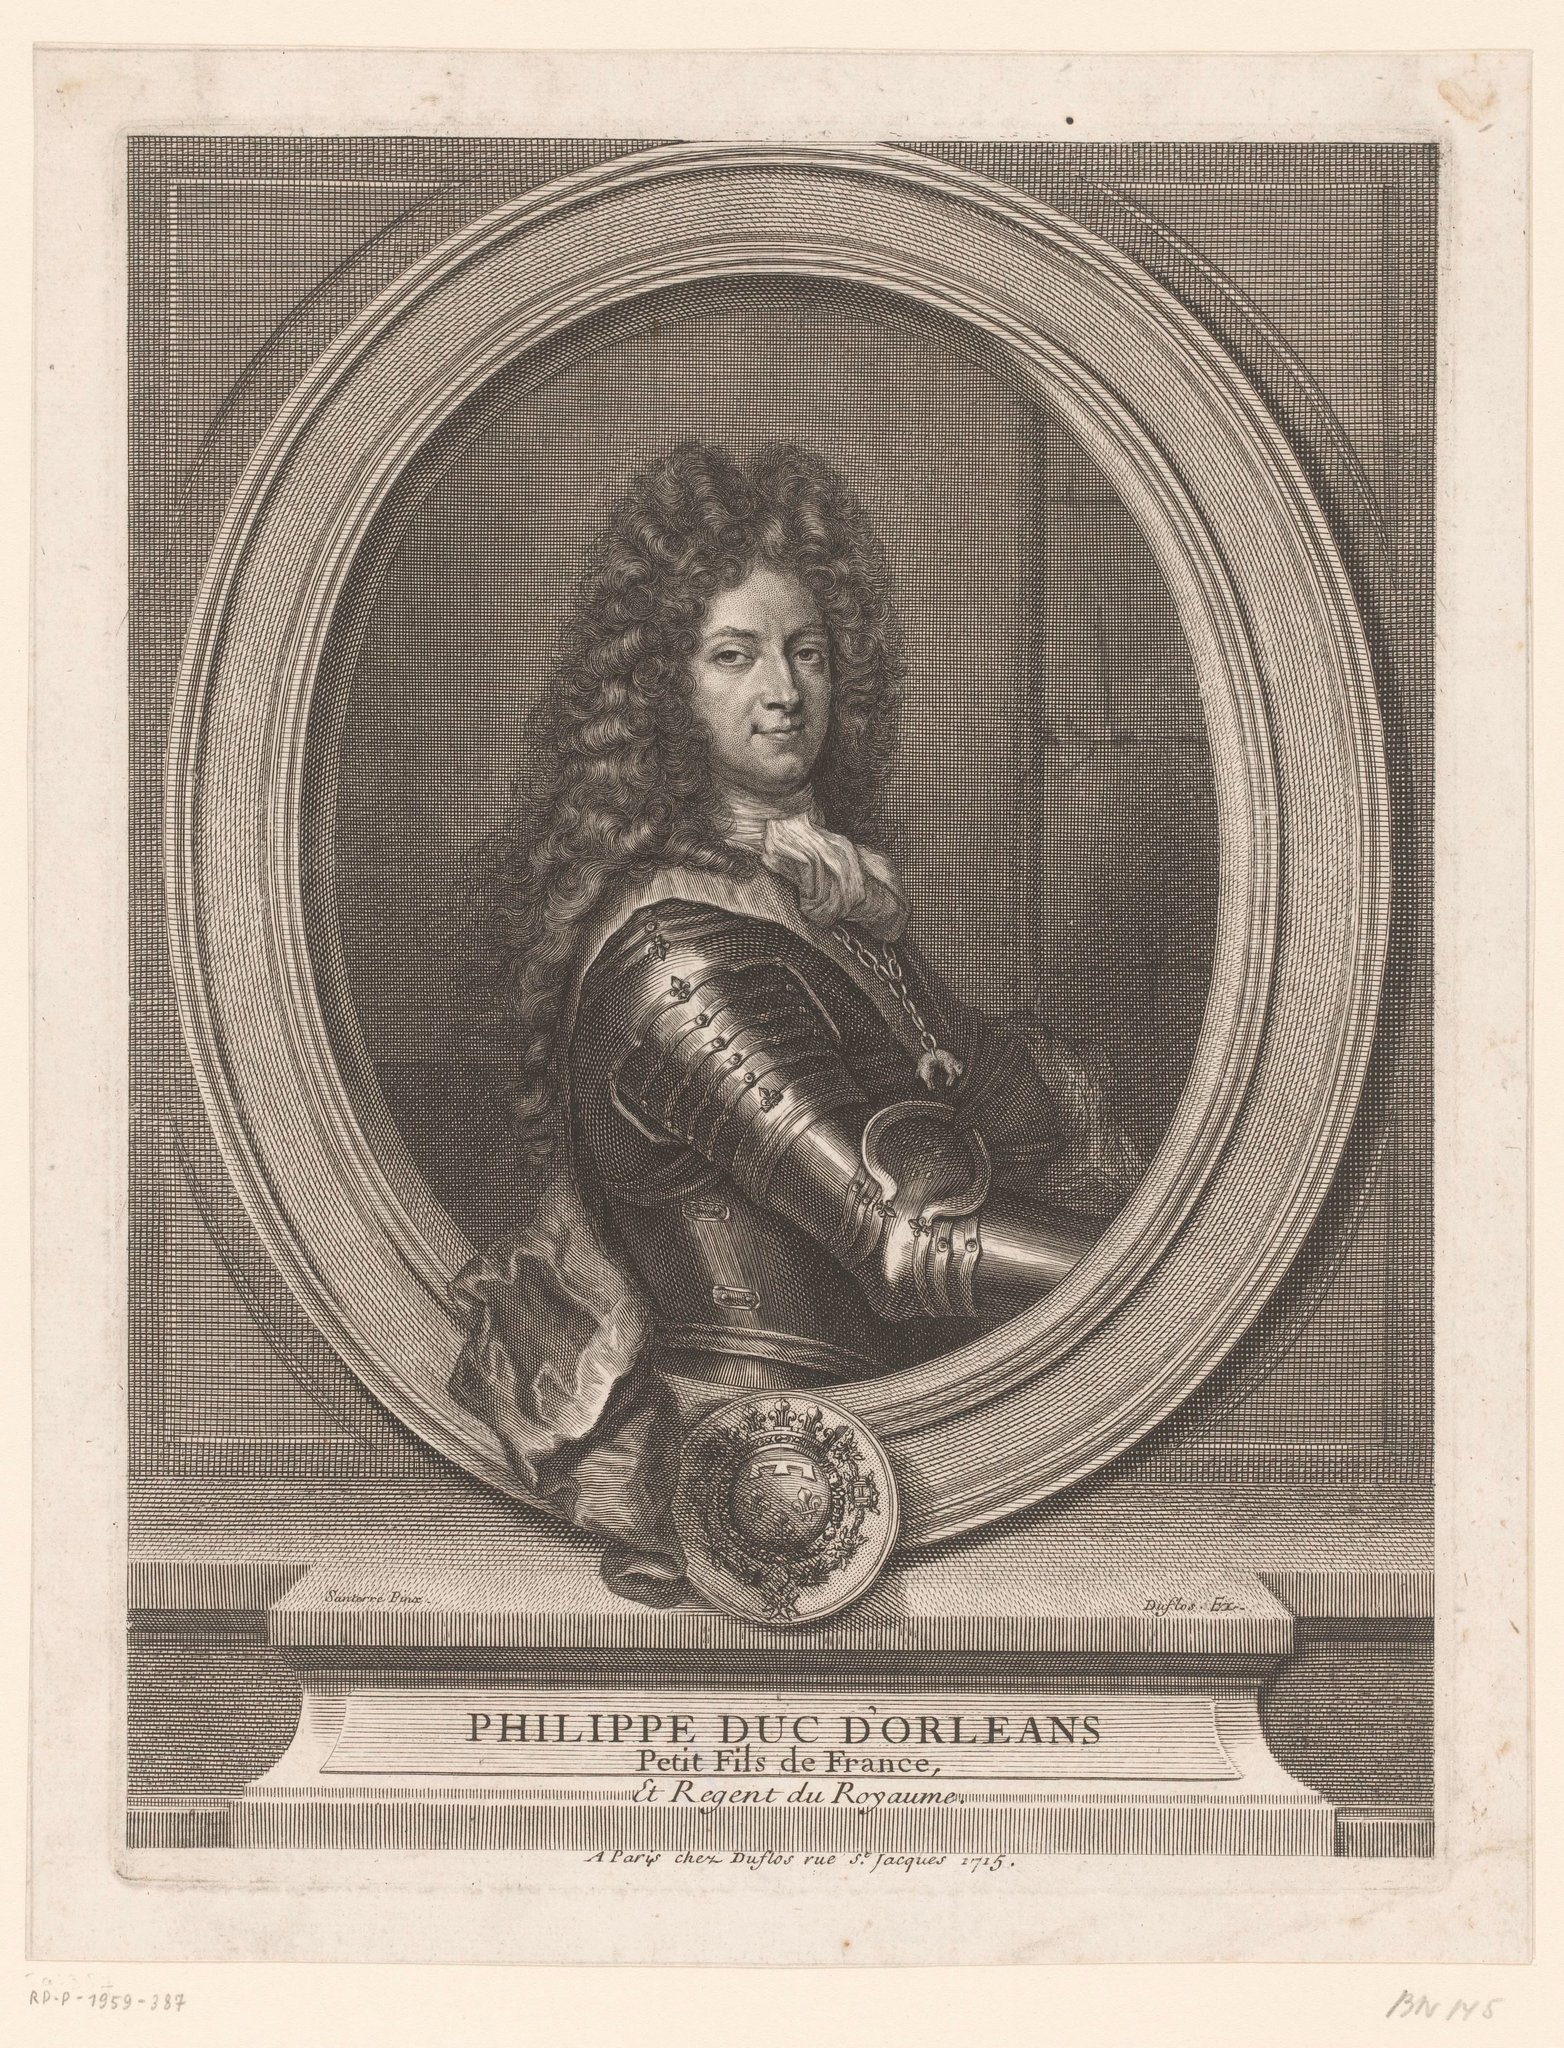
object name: print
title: Portret van Filips van Orléans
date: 1715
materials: paper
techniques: engraving, etching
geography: france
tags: paris, philippe duc d' orléans, ornament ~ medallion, historical persons, ruler, sovereign, armorial bearing, heraldry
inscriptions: collector's mark: Lugt 2228, collector's mark: Lugt 2760